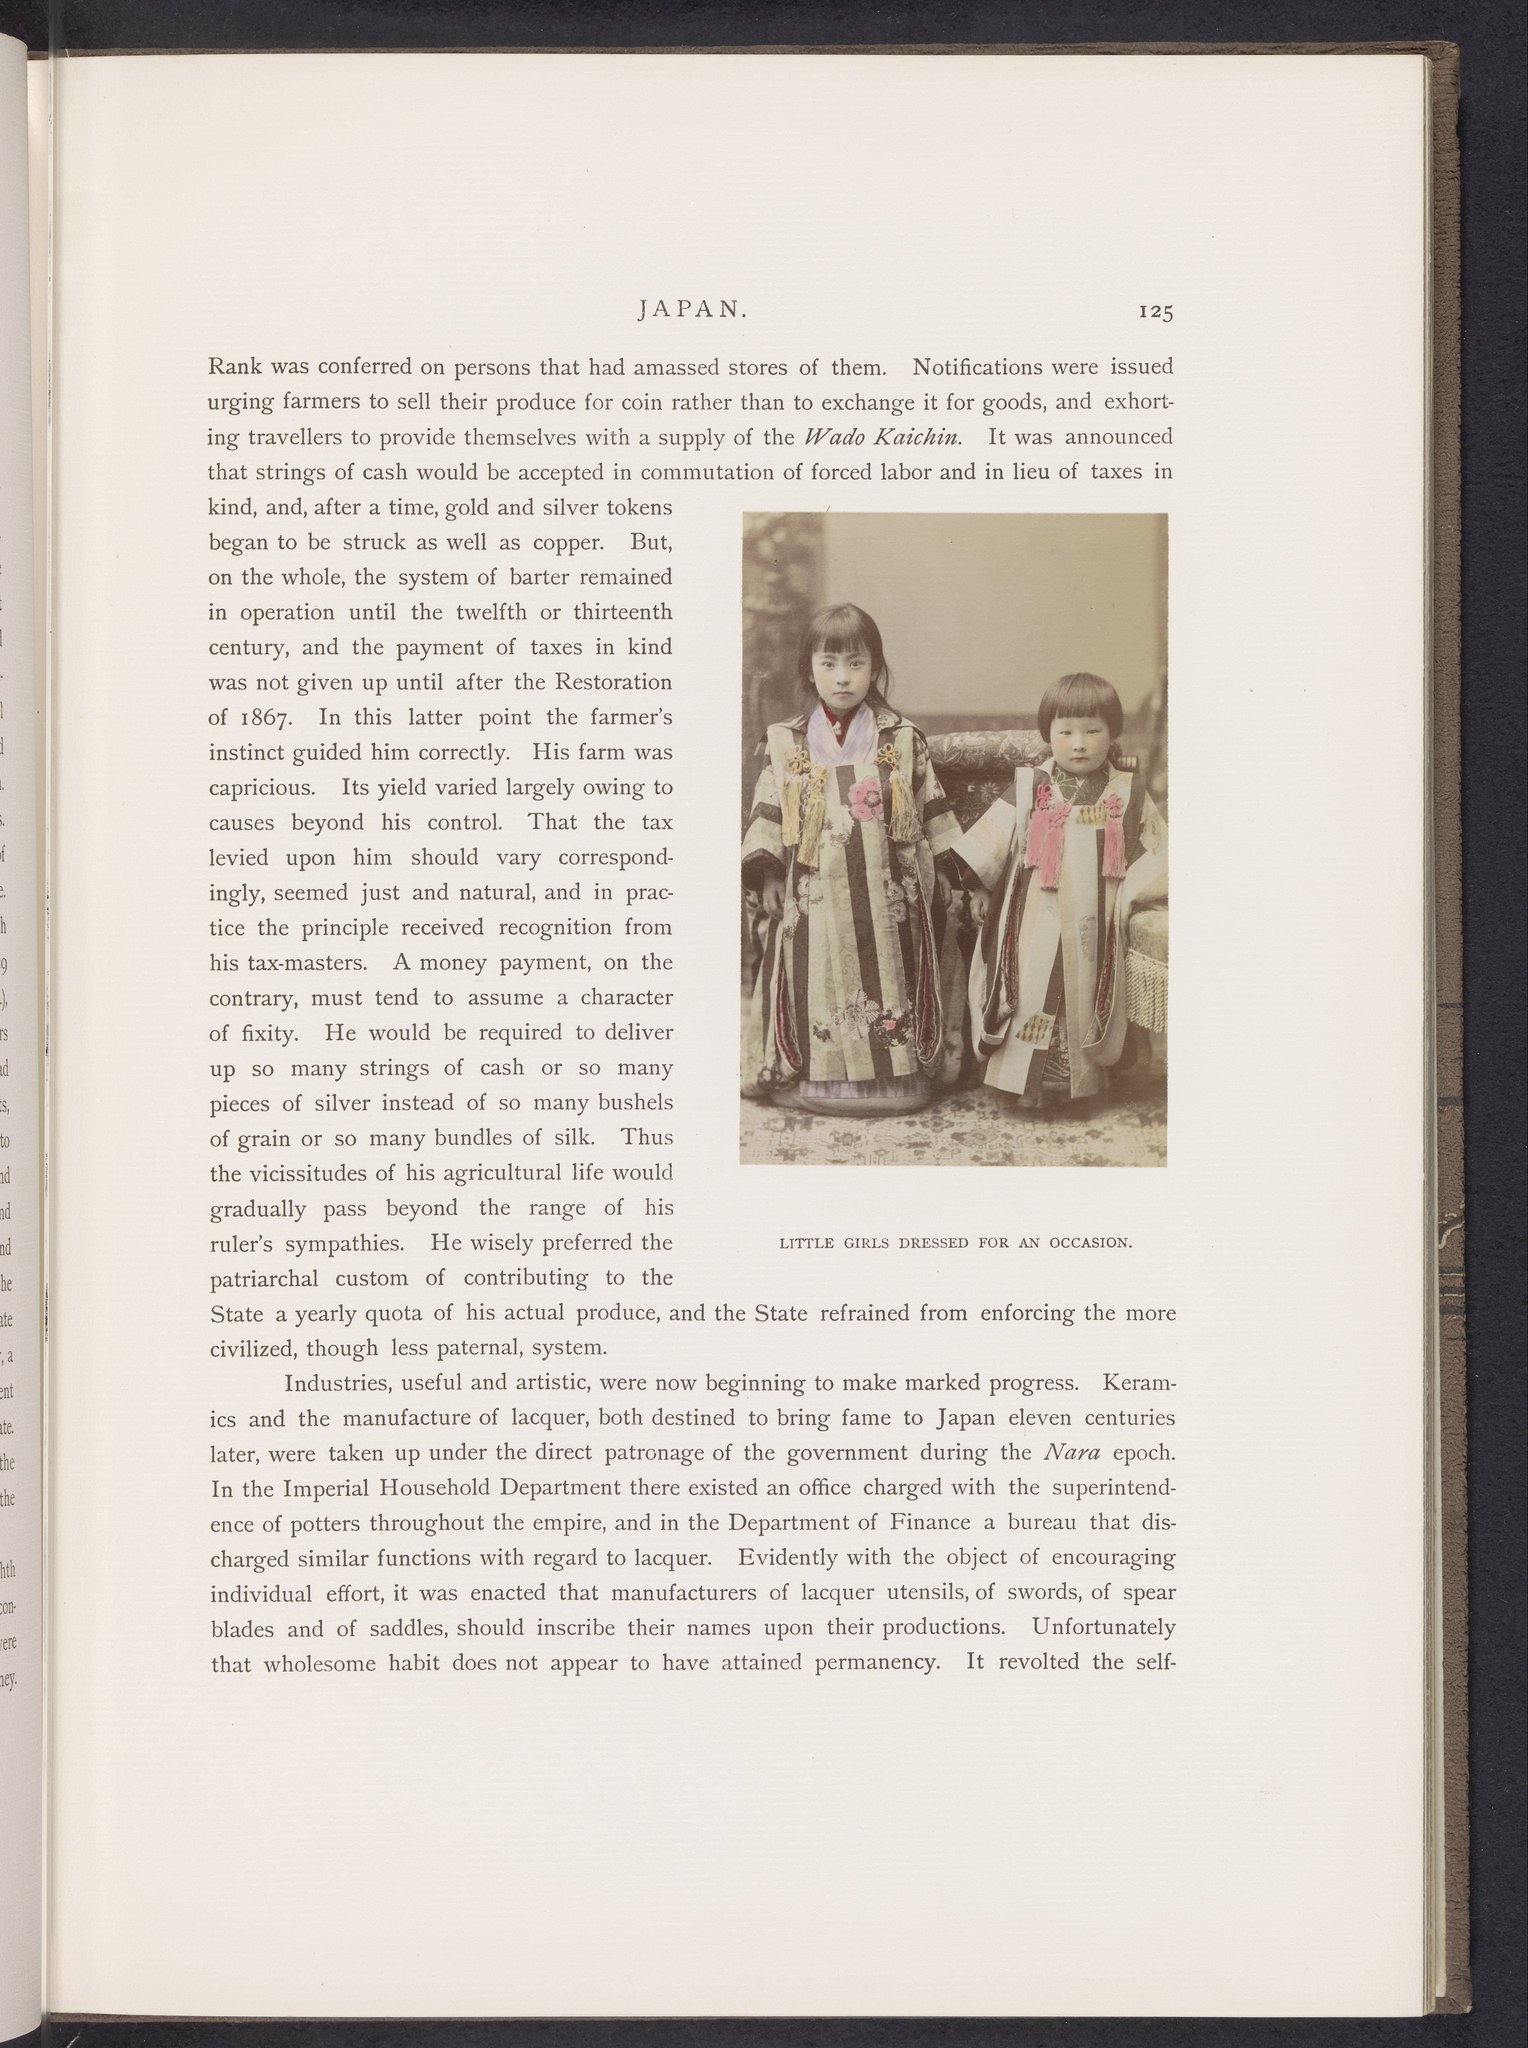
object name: photograph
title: Little girls dressed for an occasion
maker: Anonymous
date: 1887-1897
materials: photographic support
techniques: albumen print, hand coloring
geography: japan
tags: child (at home) - aa - girl, dress, gown